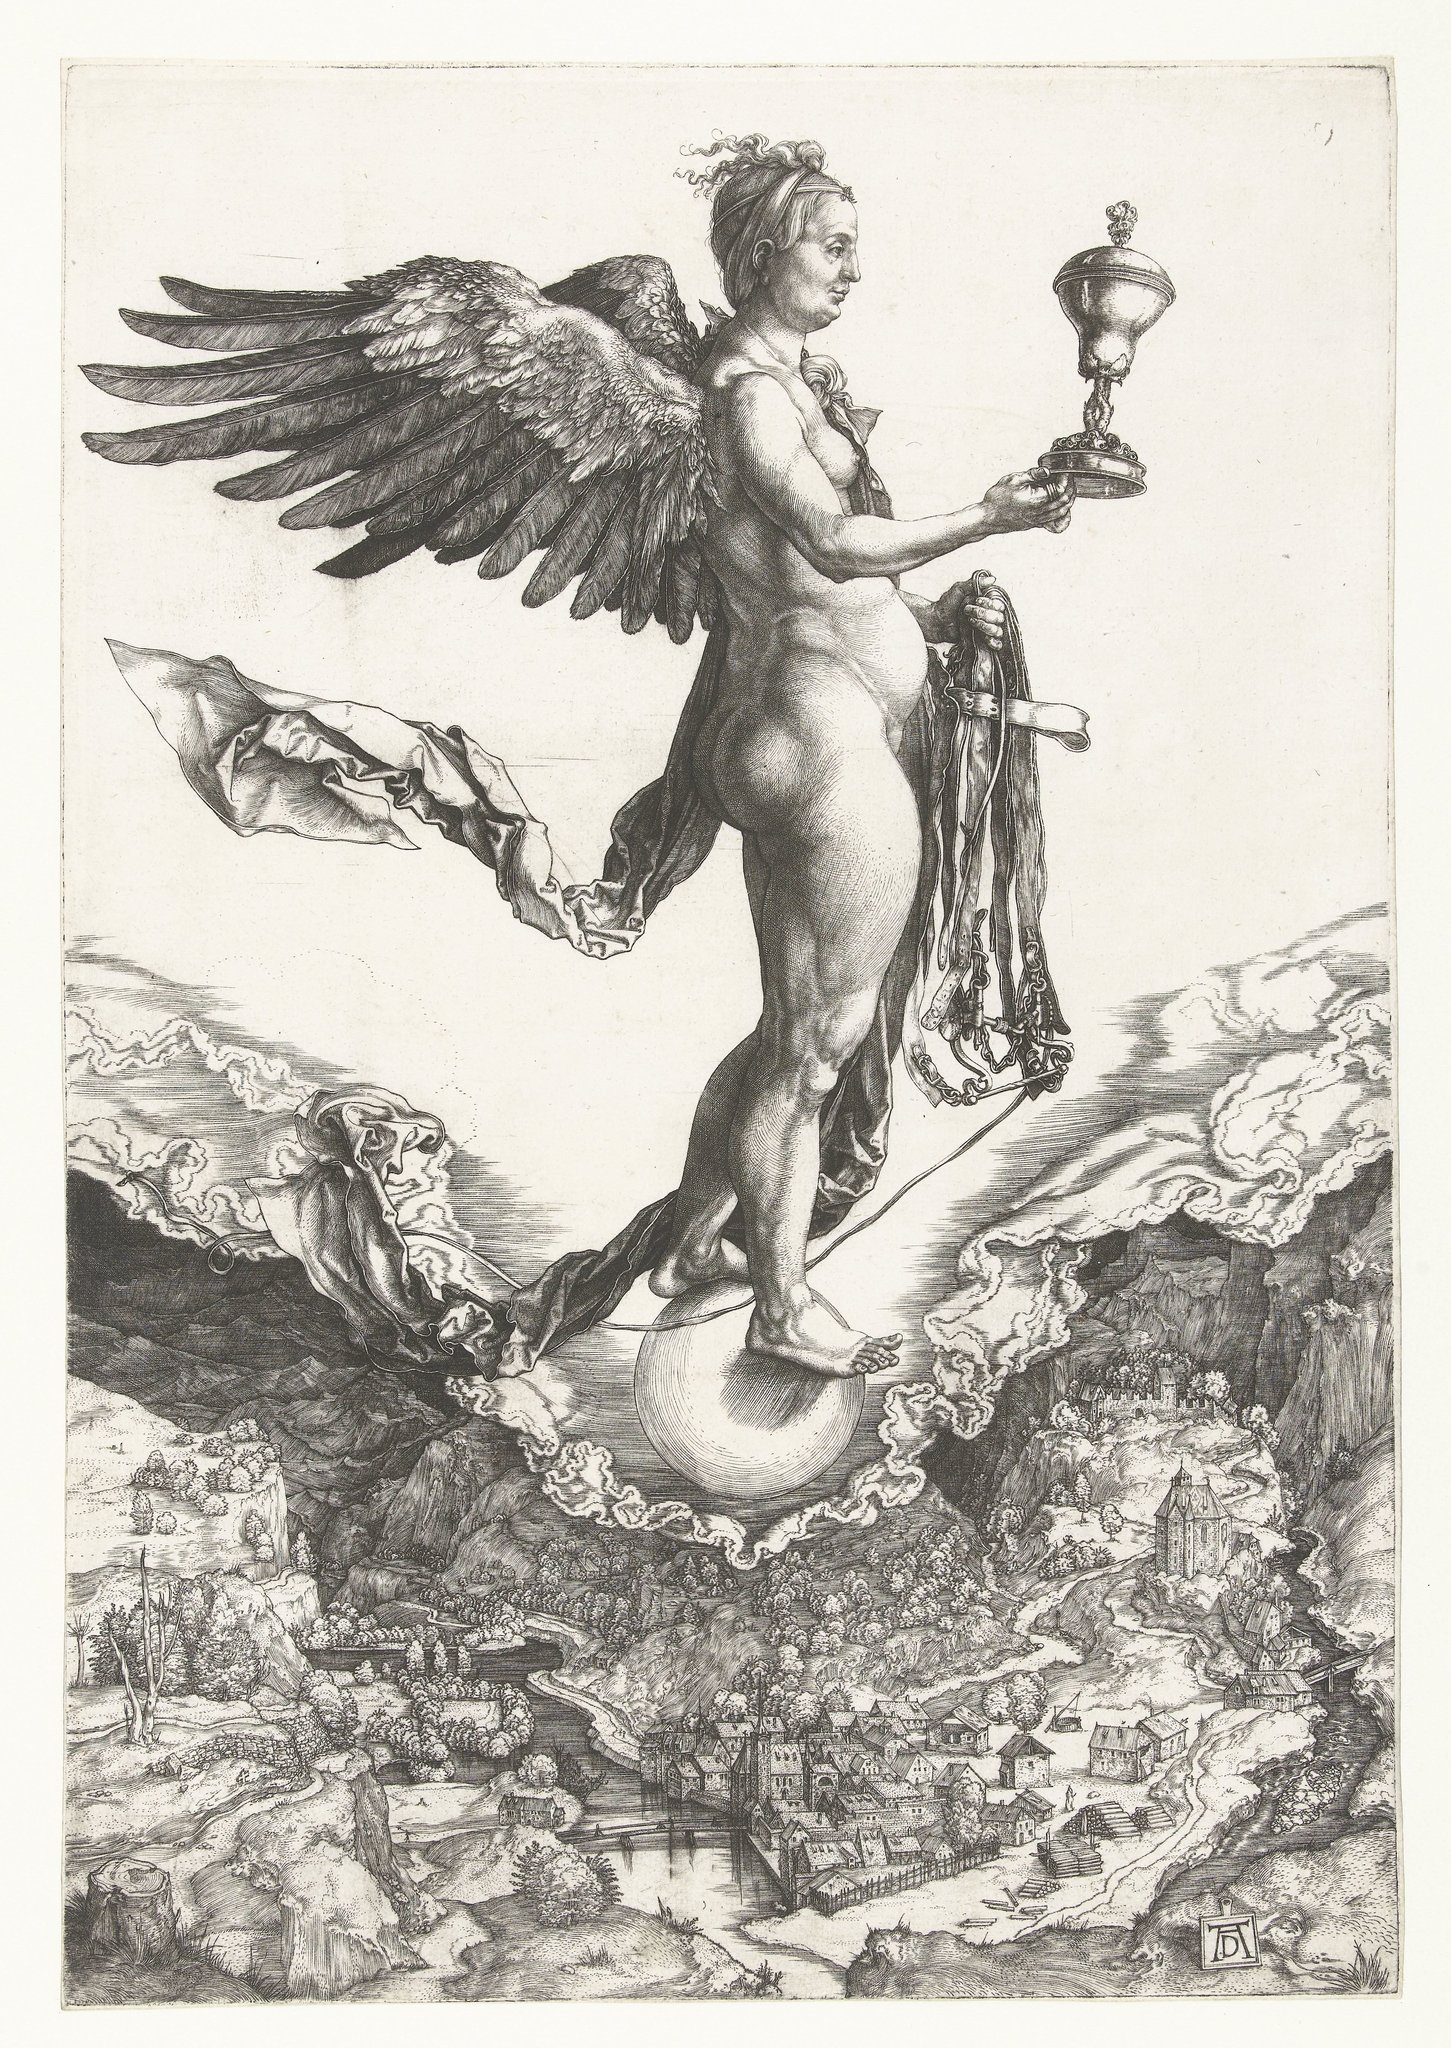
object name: print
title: Nemesis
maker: albrecht dürer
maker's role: draughtsman, painter, print maker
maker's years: 1471-1528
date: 1499-1503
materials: paper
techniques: engraving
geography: nuremberg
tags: nemesis (adrastea), luck, fortune, lot; 'fato', 'fortuna', 'fortuna aurea', 'fortuna buona', 'fortuna pacifica overo clemente', 'sorte' (ripa)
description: Een gevleugelde vrouw met een beker in de ene hand en een breidel in de andere hand, staande op een bol, zwevend boven een rivierdal met een dorp.